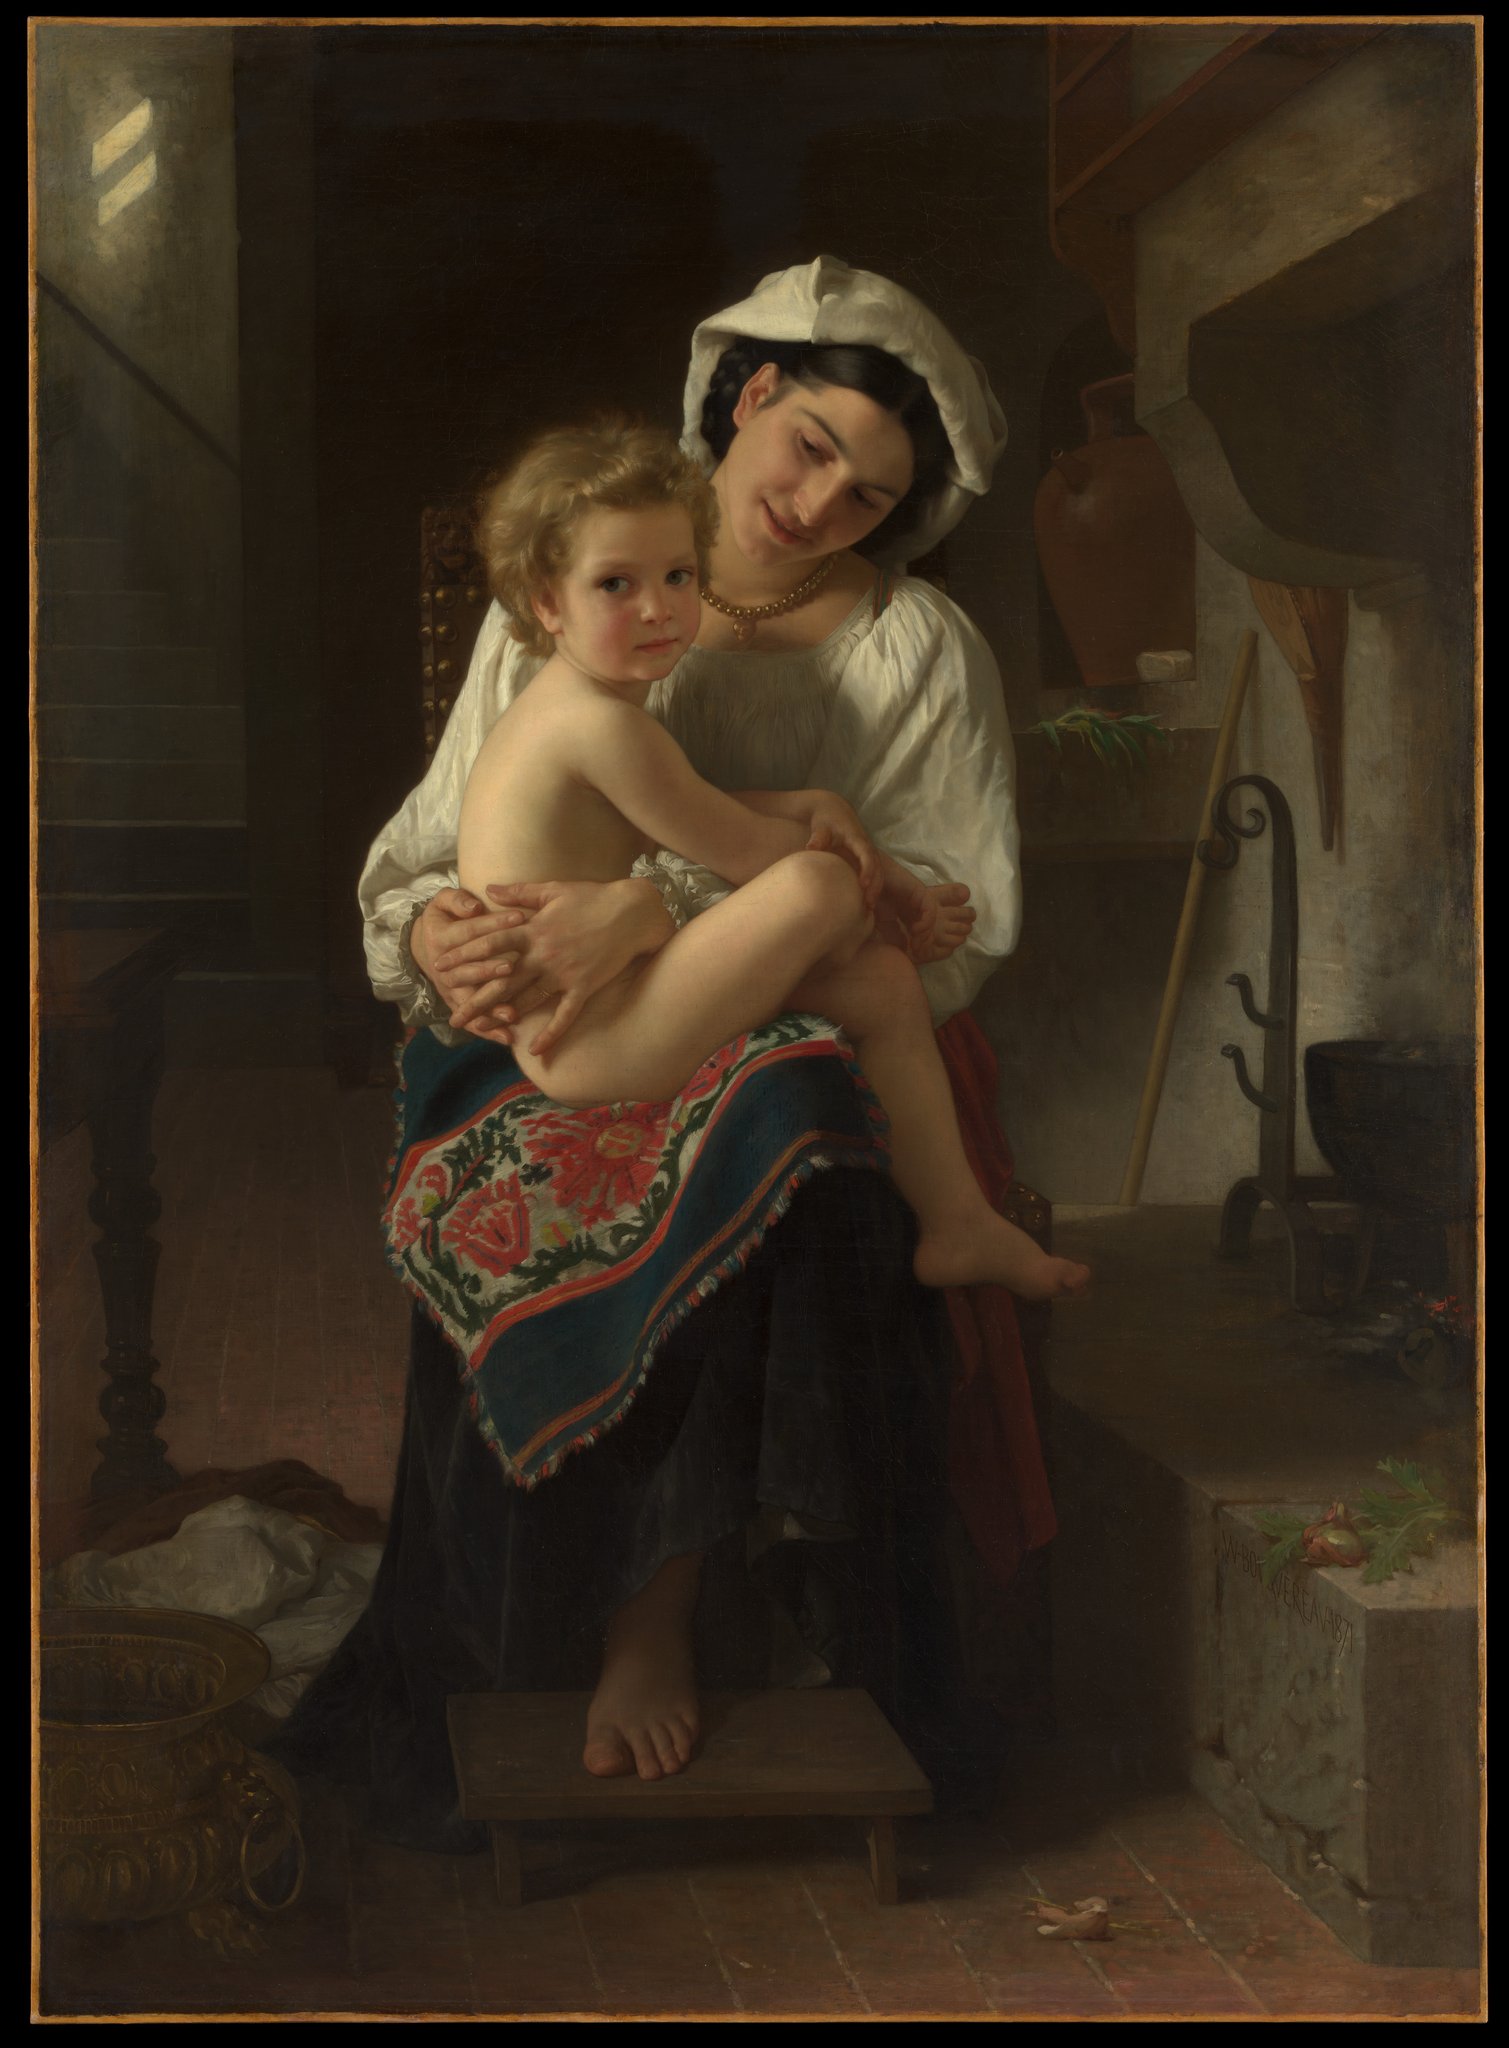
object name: painting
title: Young Mother Gazing at Her Child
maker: william bouguereau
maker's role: artist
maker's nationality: french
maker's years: 1825-1905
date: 1871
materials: canvas, oil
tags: children,mothers,women